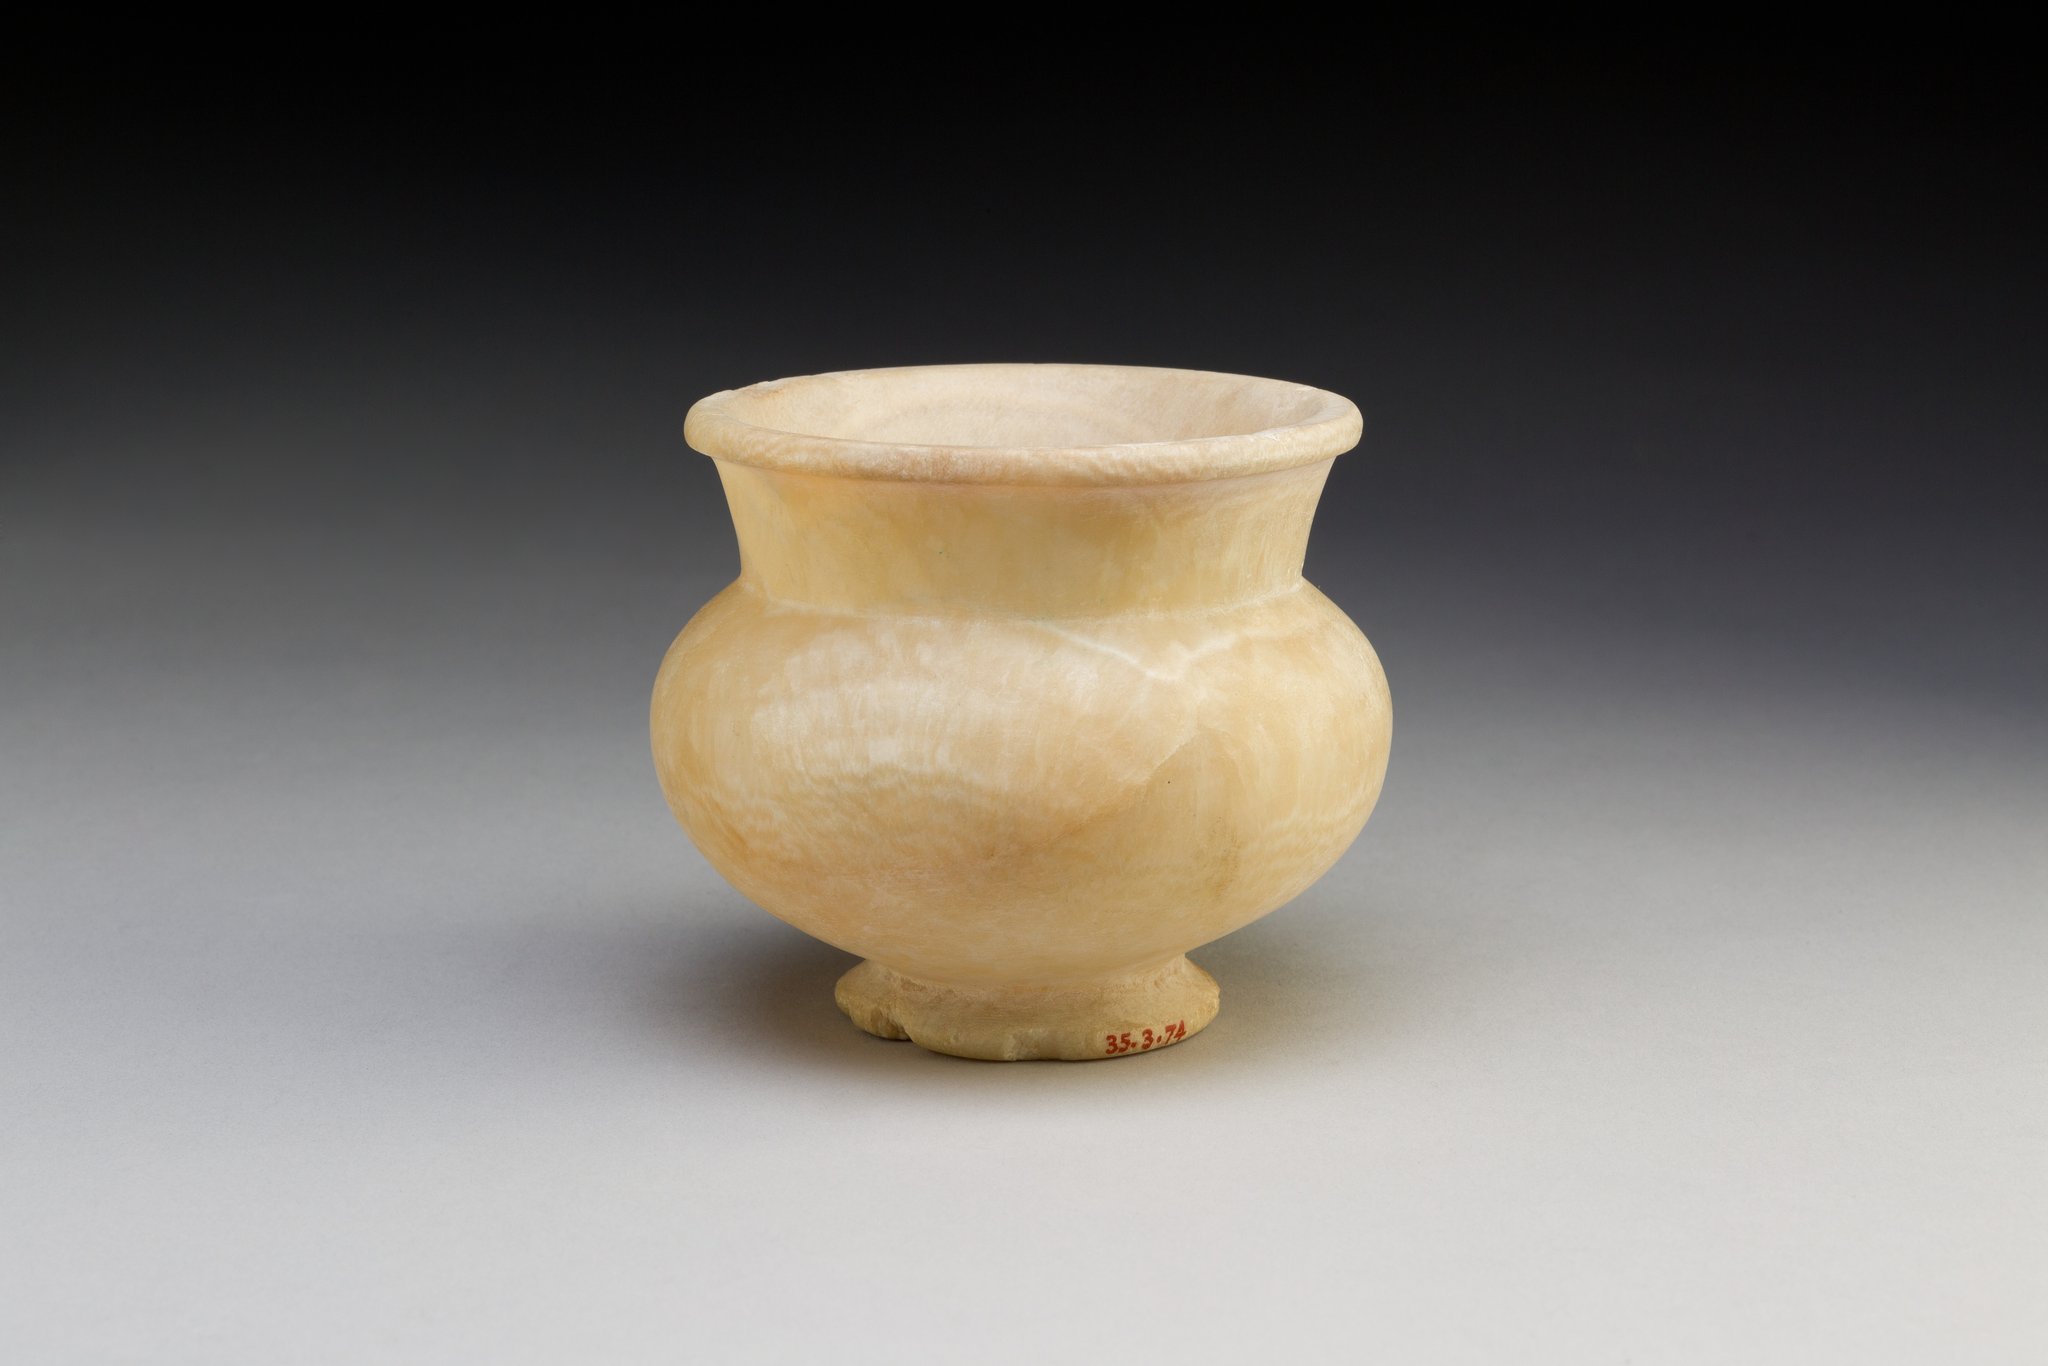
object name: jar, cosmetic, open mouthed, rennefer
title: Open-Mouthed Cosmetic Jar of Rennefer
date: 1504-1447 BCE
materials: stone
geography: egypt